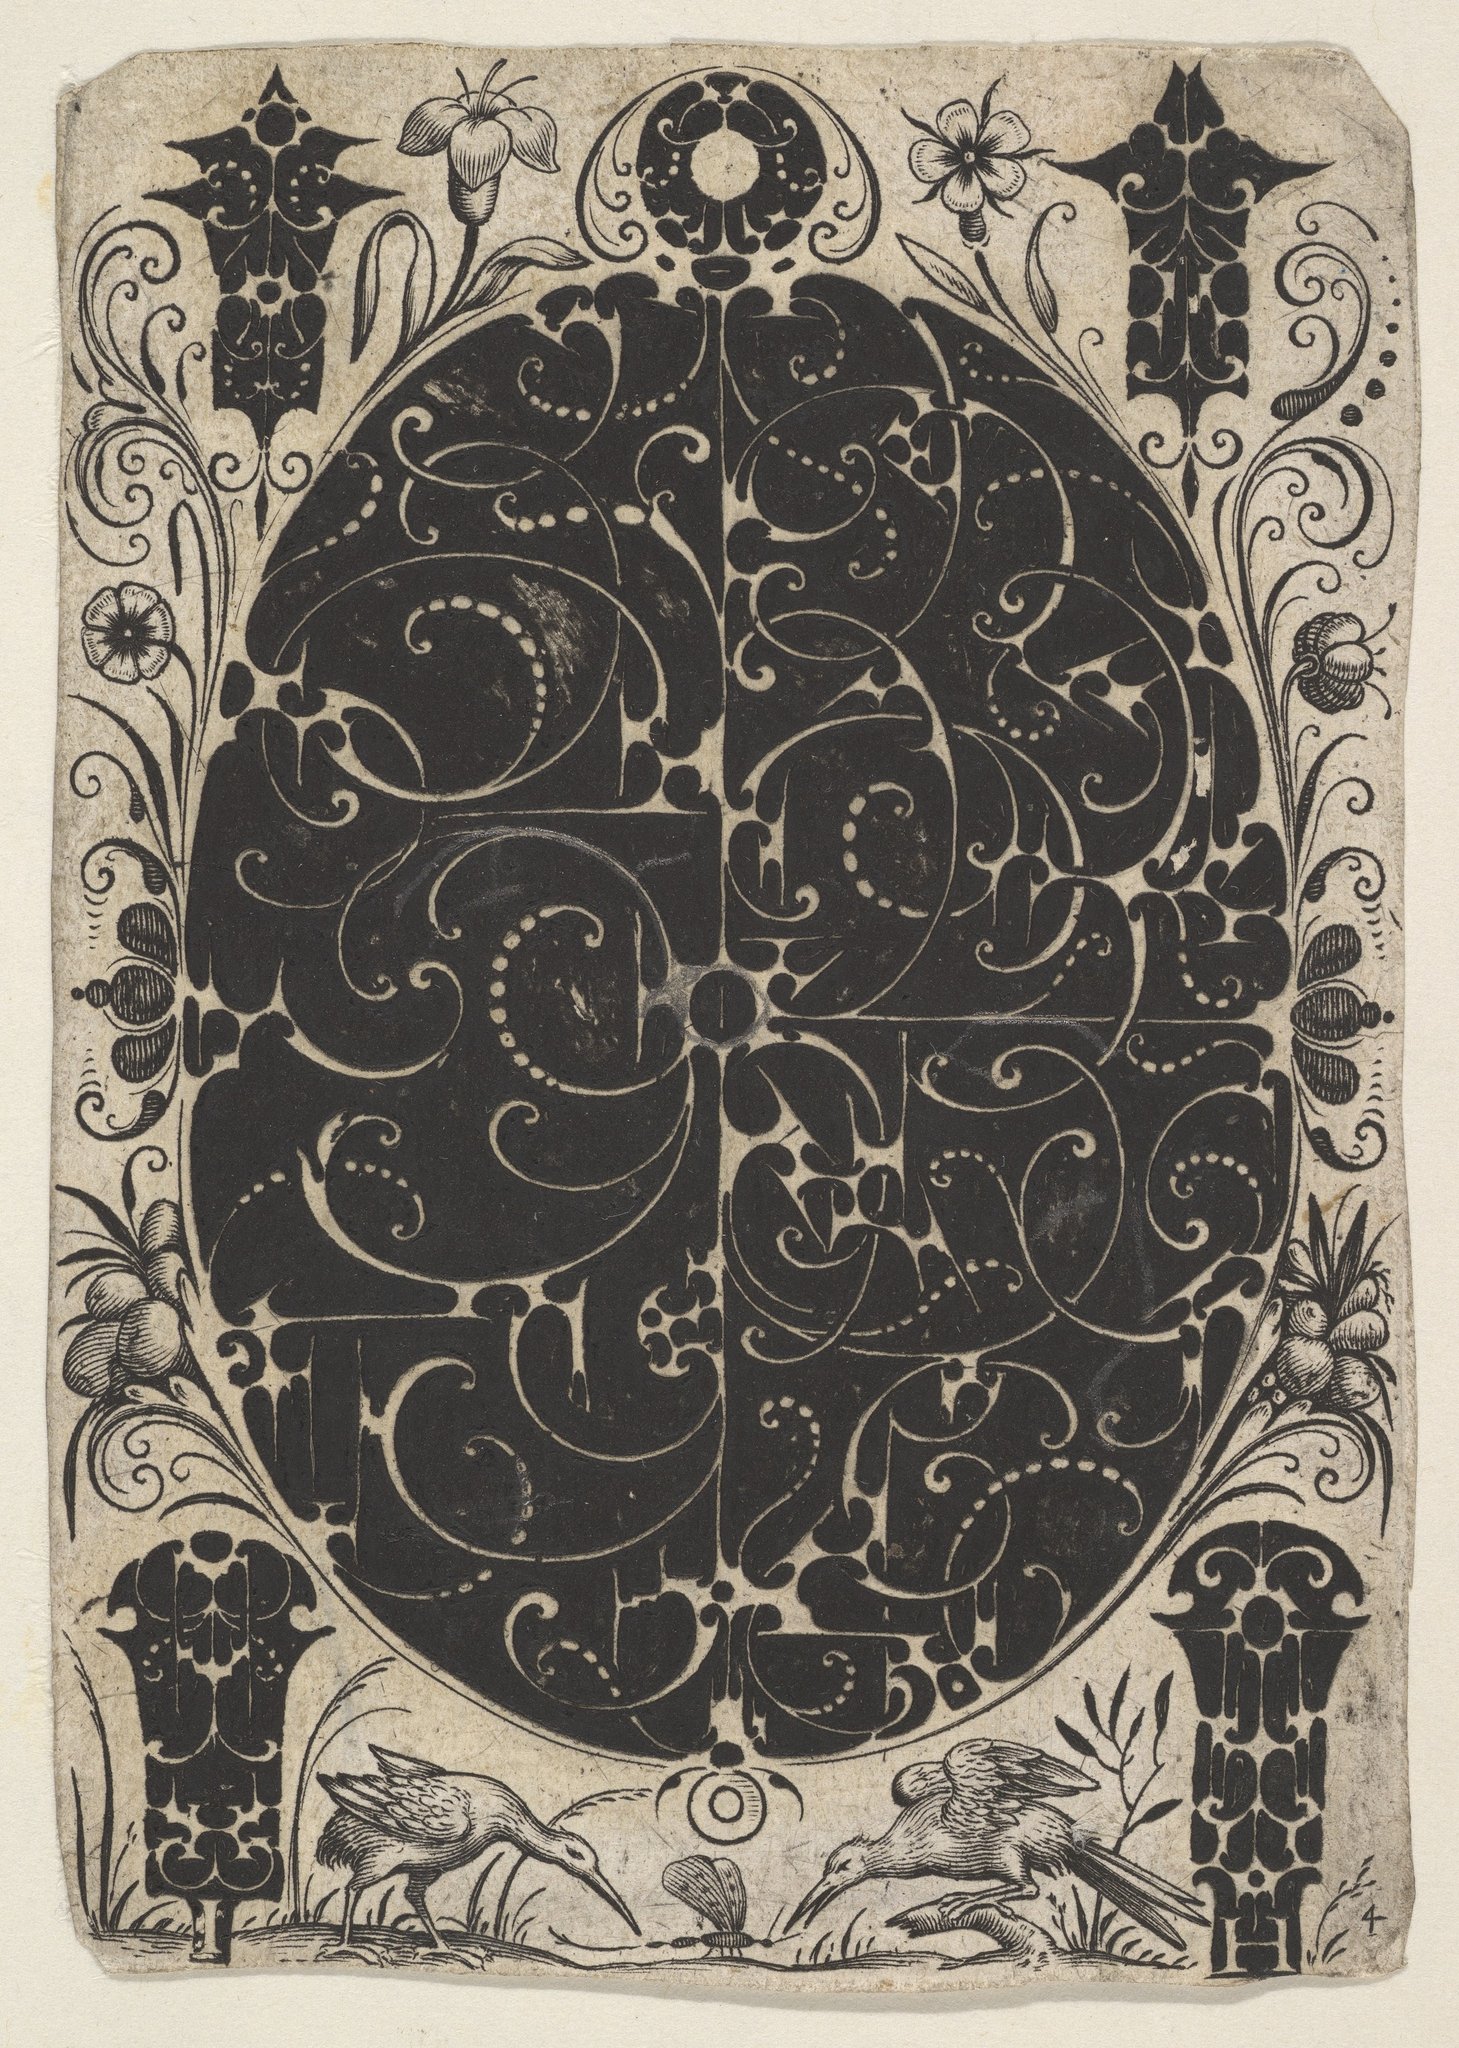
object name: print collection ornament architecture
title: Oval Case Decorated with Schweifwerk in Two Variants, Surrounded by Smaller Motifs, Flowers and Two Birds Below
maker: jacques hurtu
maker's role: artist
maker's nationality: french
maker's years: 1584-1635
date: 1614-1619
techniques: embroidery, engraving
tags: birds,ornament